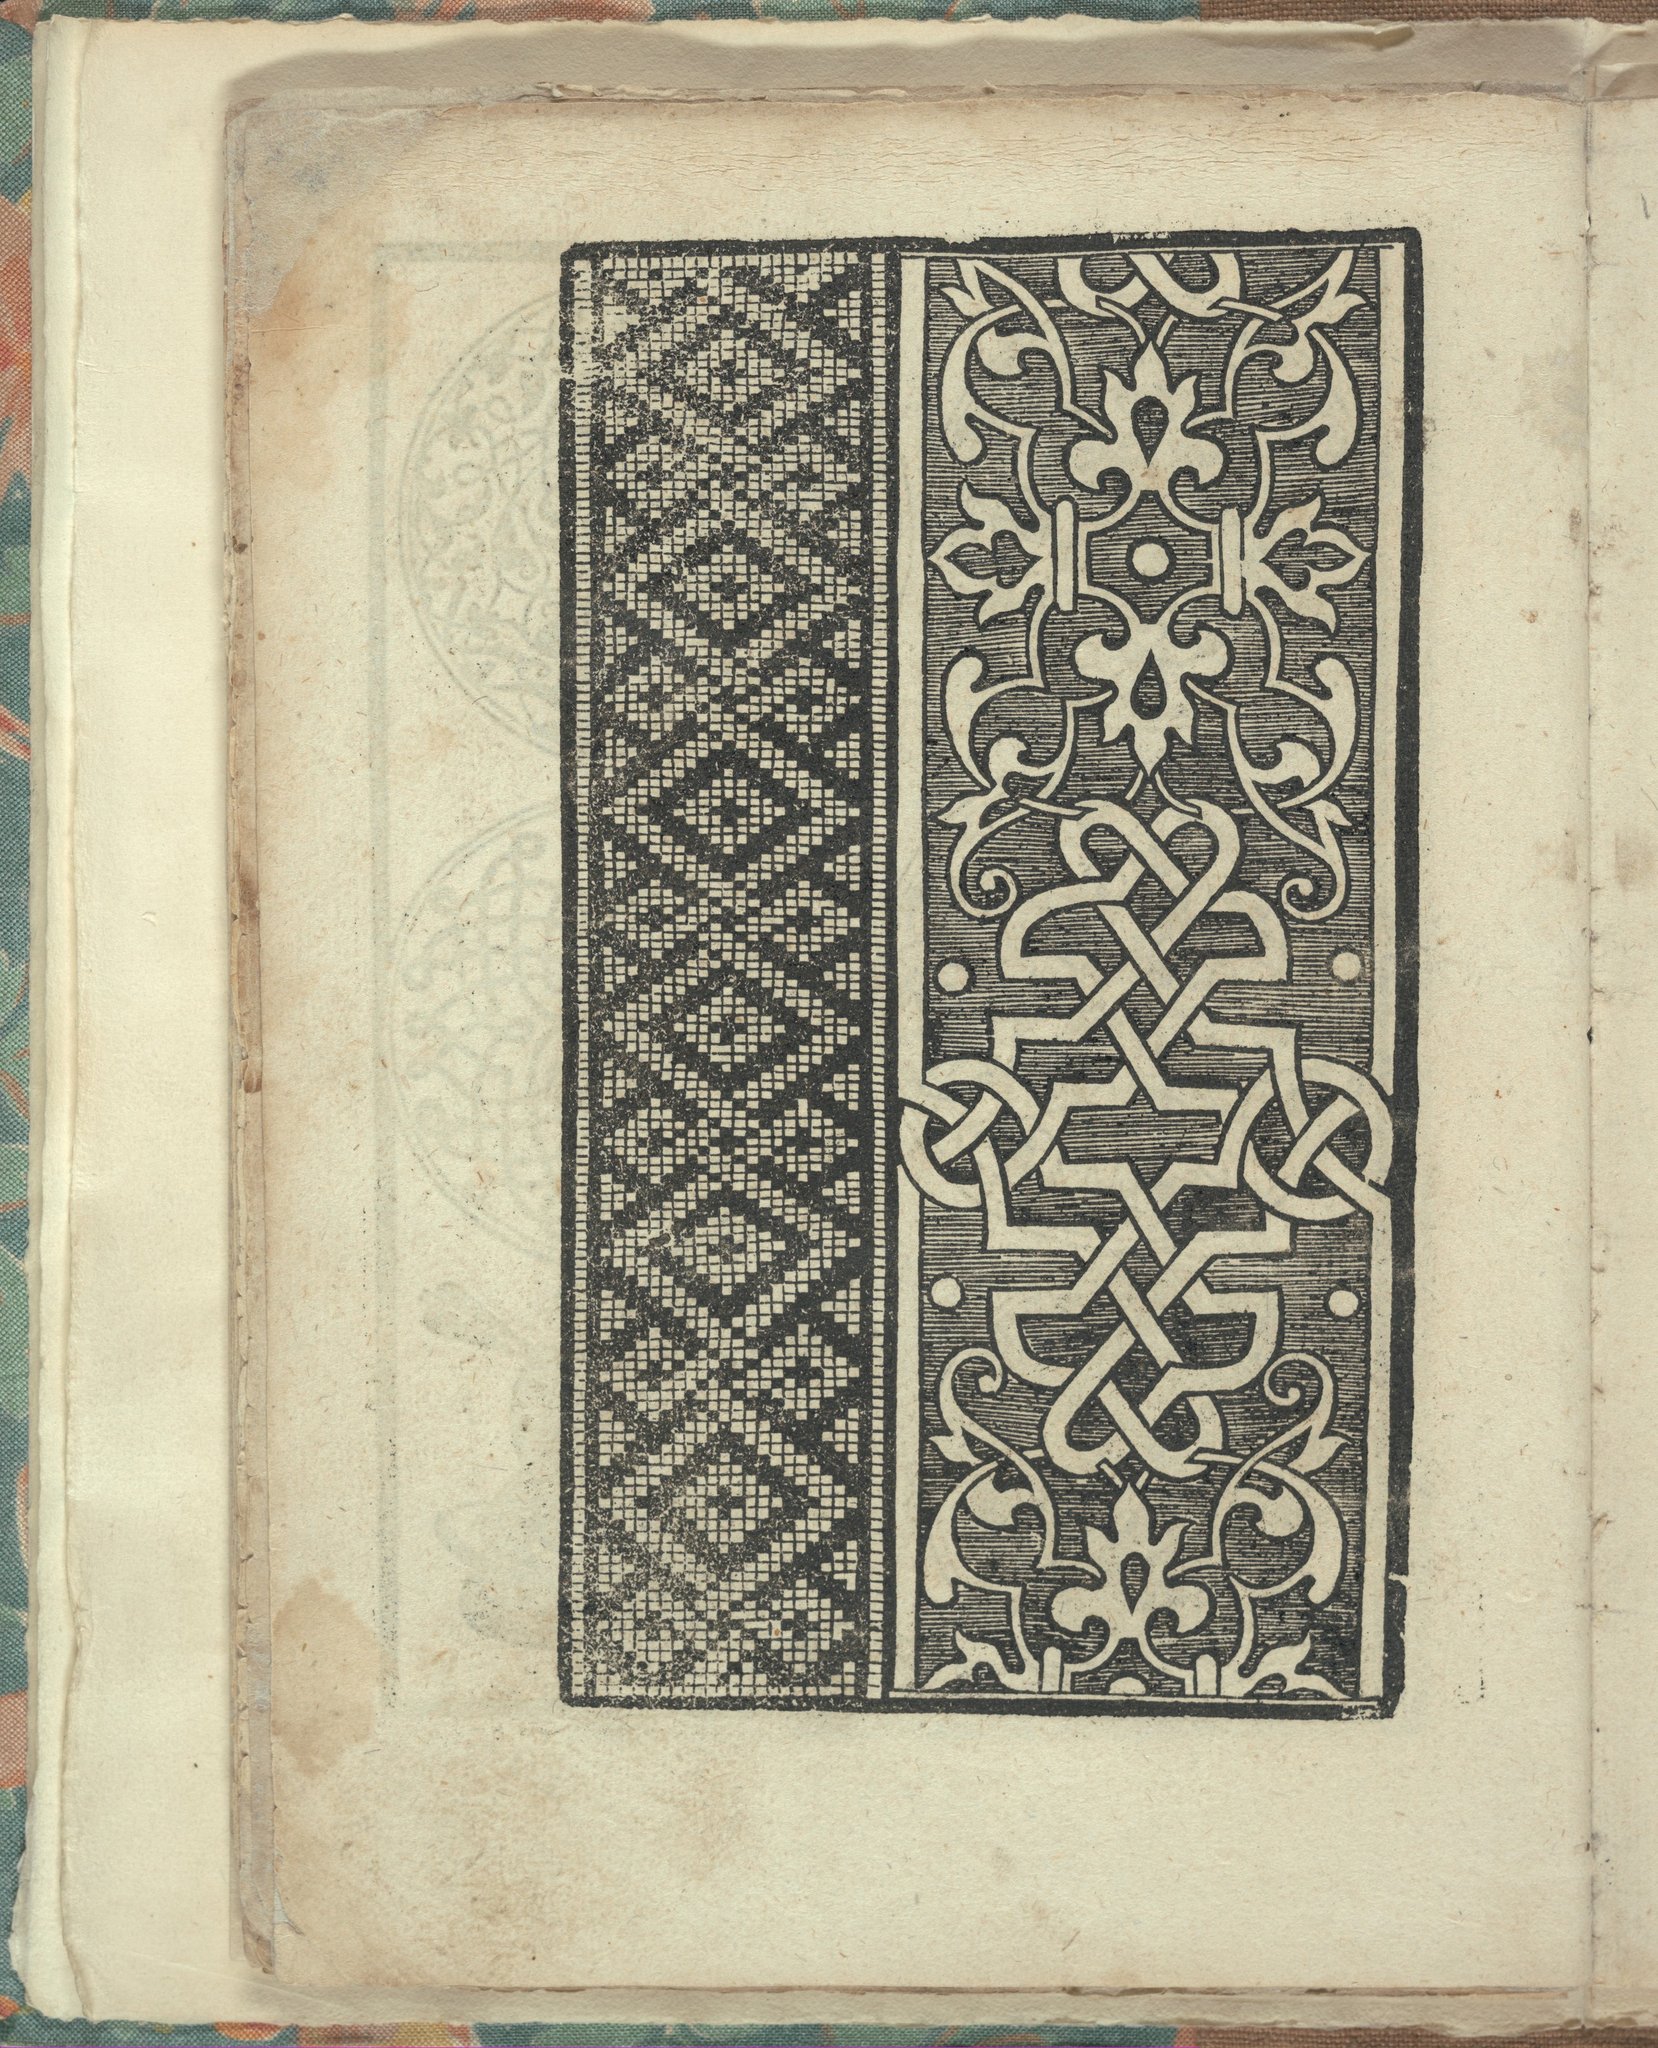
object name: book print ornament architecture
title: Opera Nova Universali intitulata Corona di racammi, page 28 (verso)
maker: giovanni andrea vavassore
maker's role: publisher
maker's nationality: italian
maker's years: 1530-1573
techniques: woodcut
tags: ornament